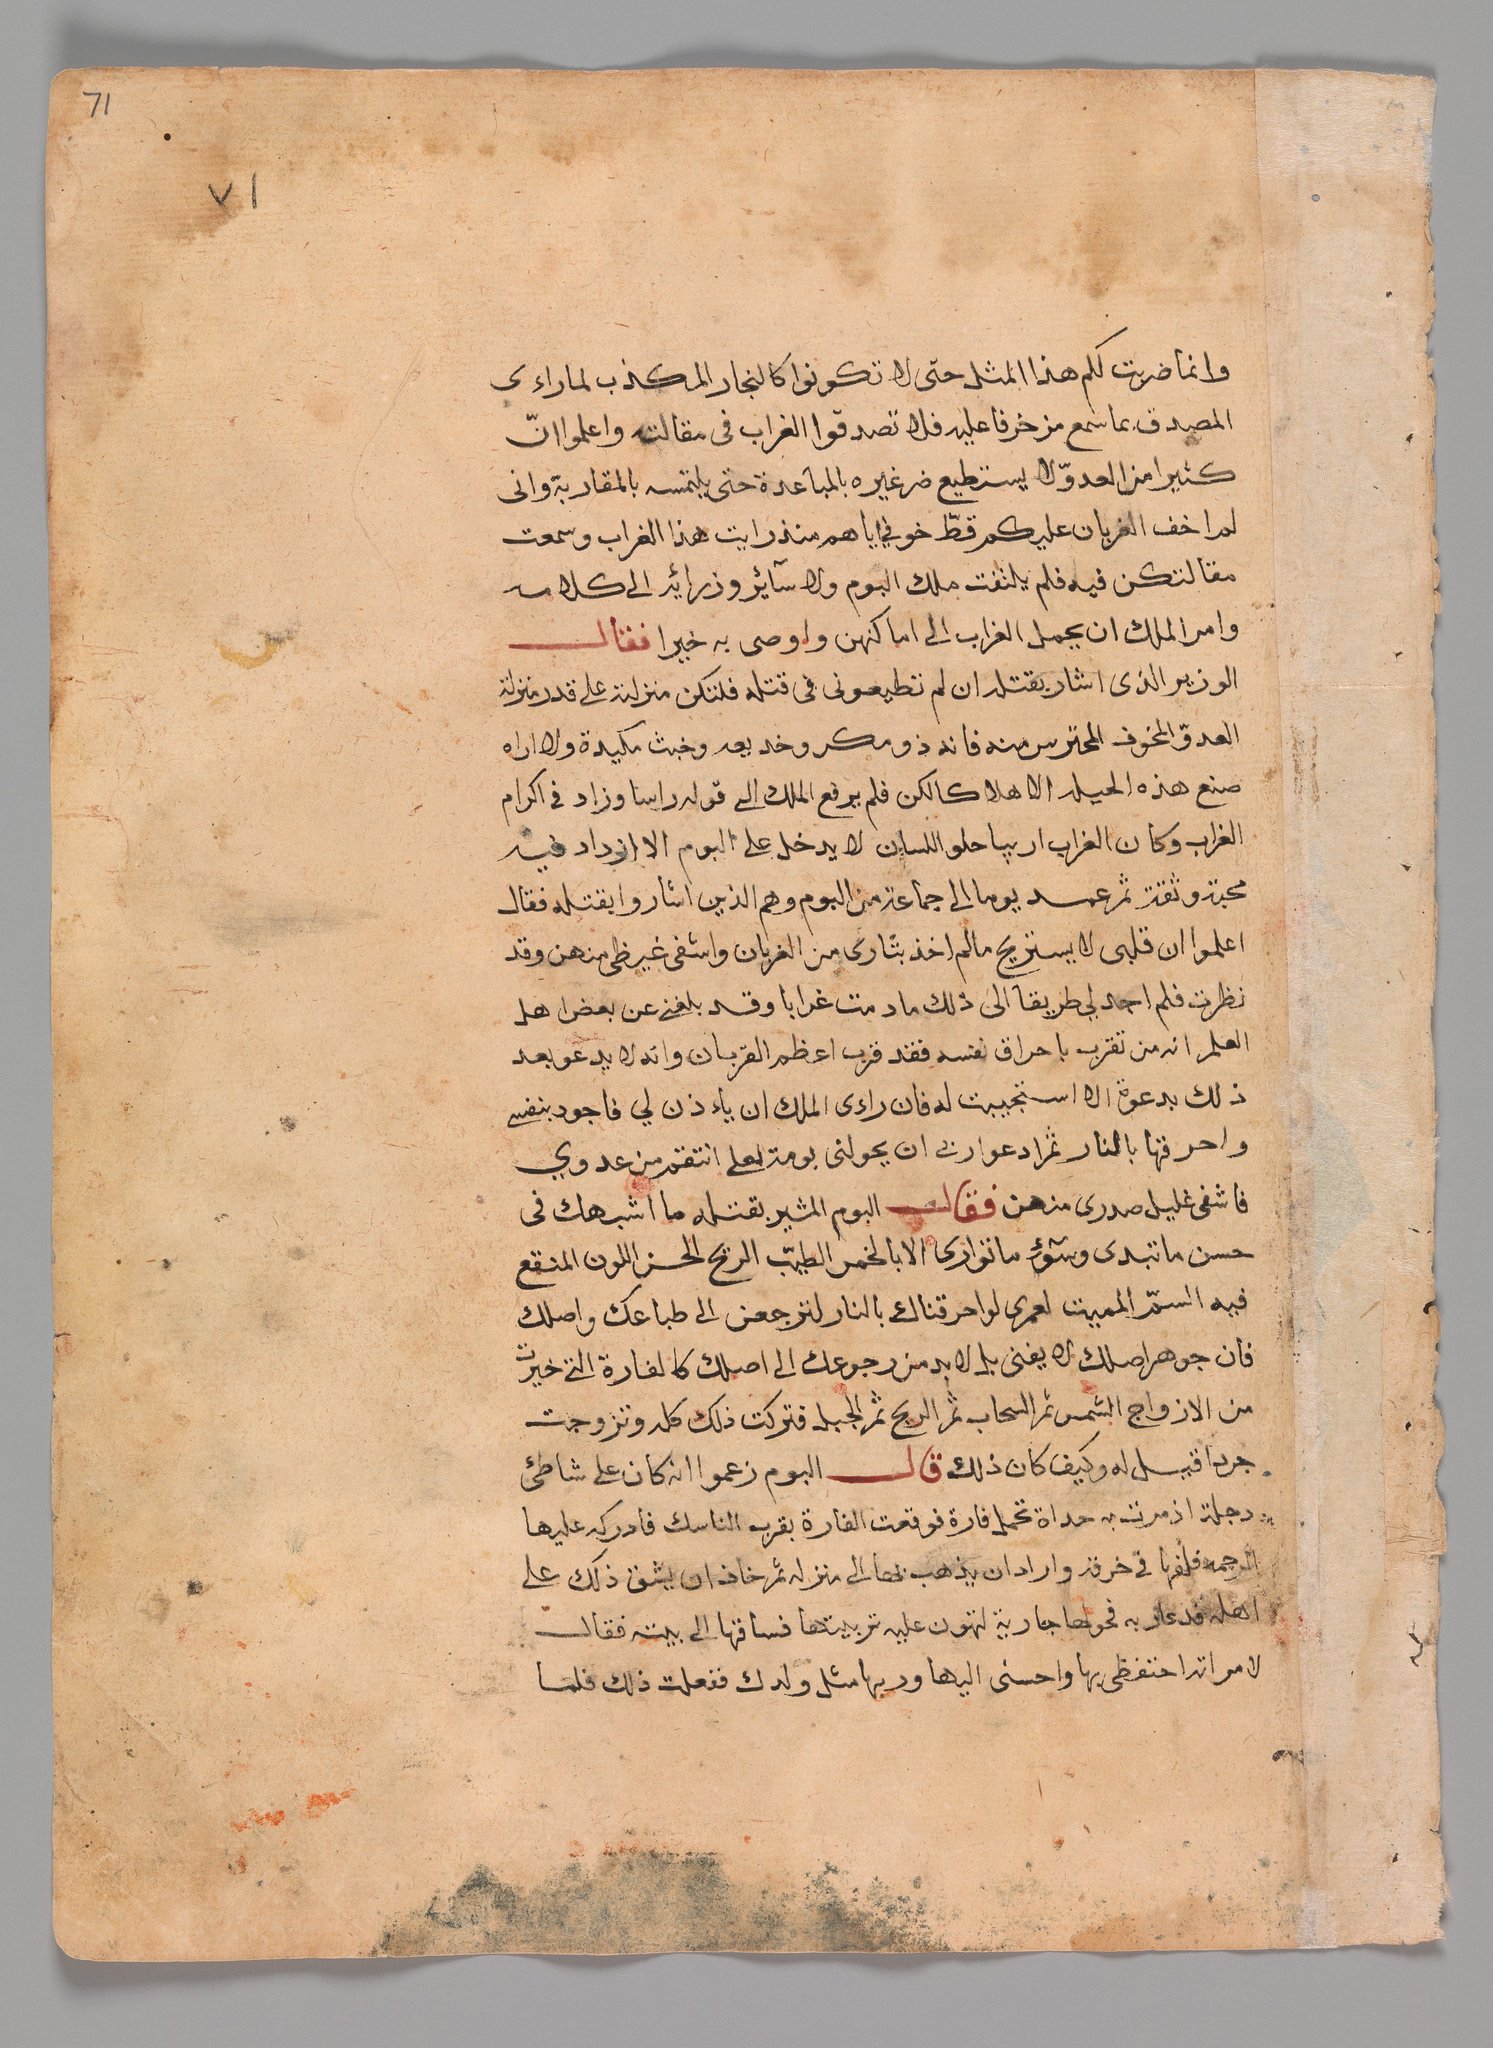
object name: folio from an illustrated manuscript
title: Page of Calligraphy from a Kalila wa Dimna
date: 1526-1550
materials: ink, paper, watercolor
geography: india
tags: arabic,calligraphy